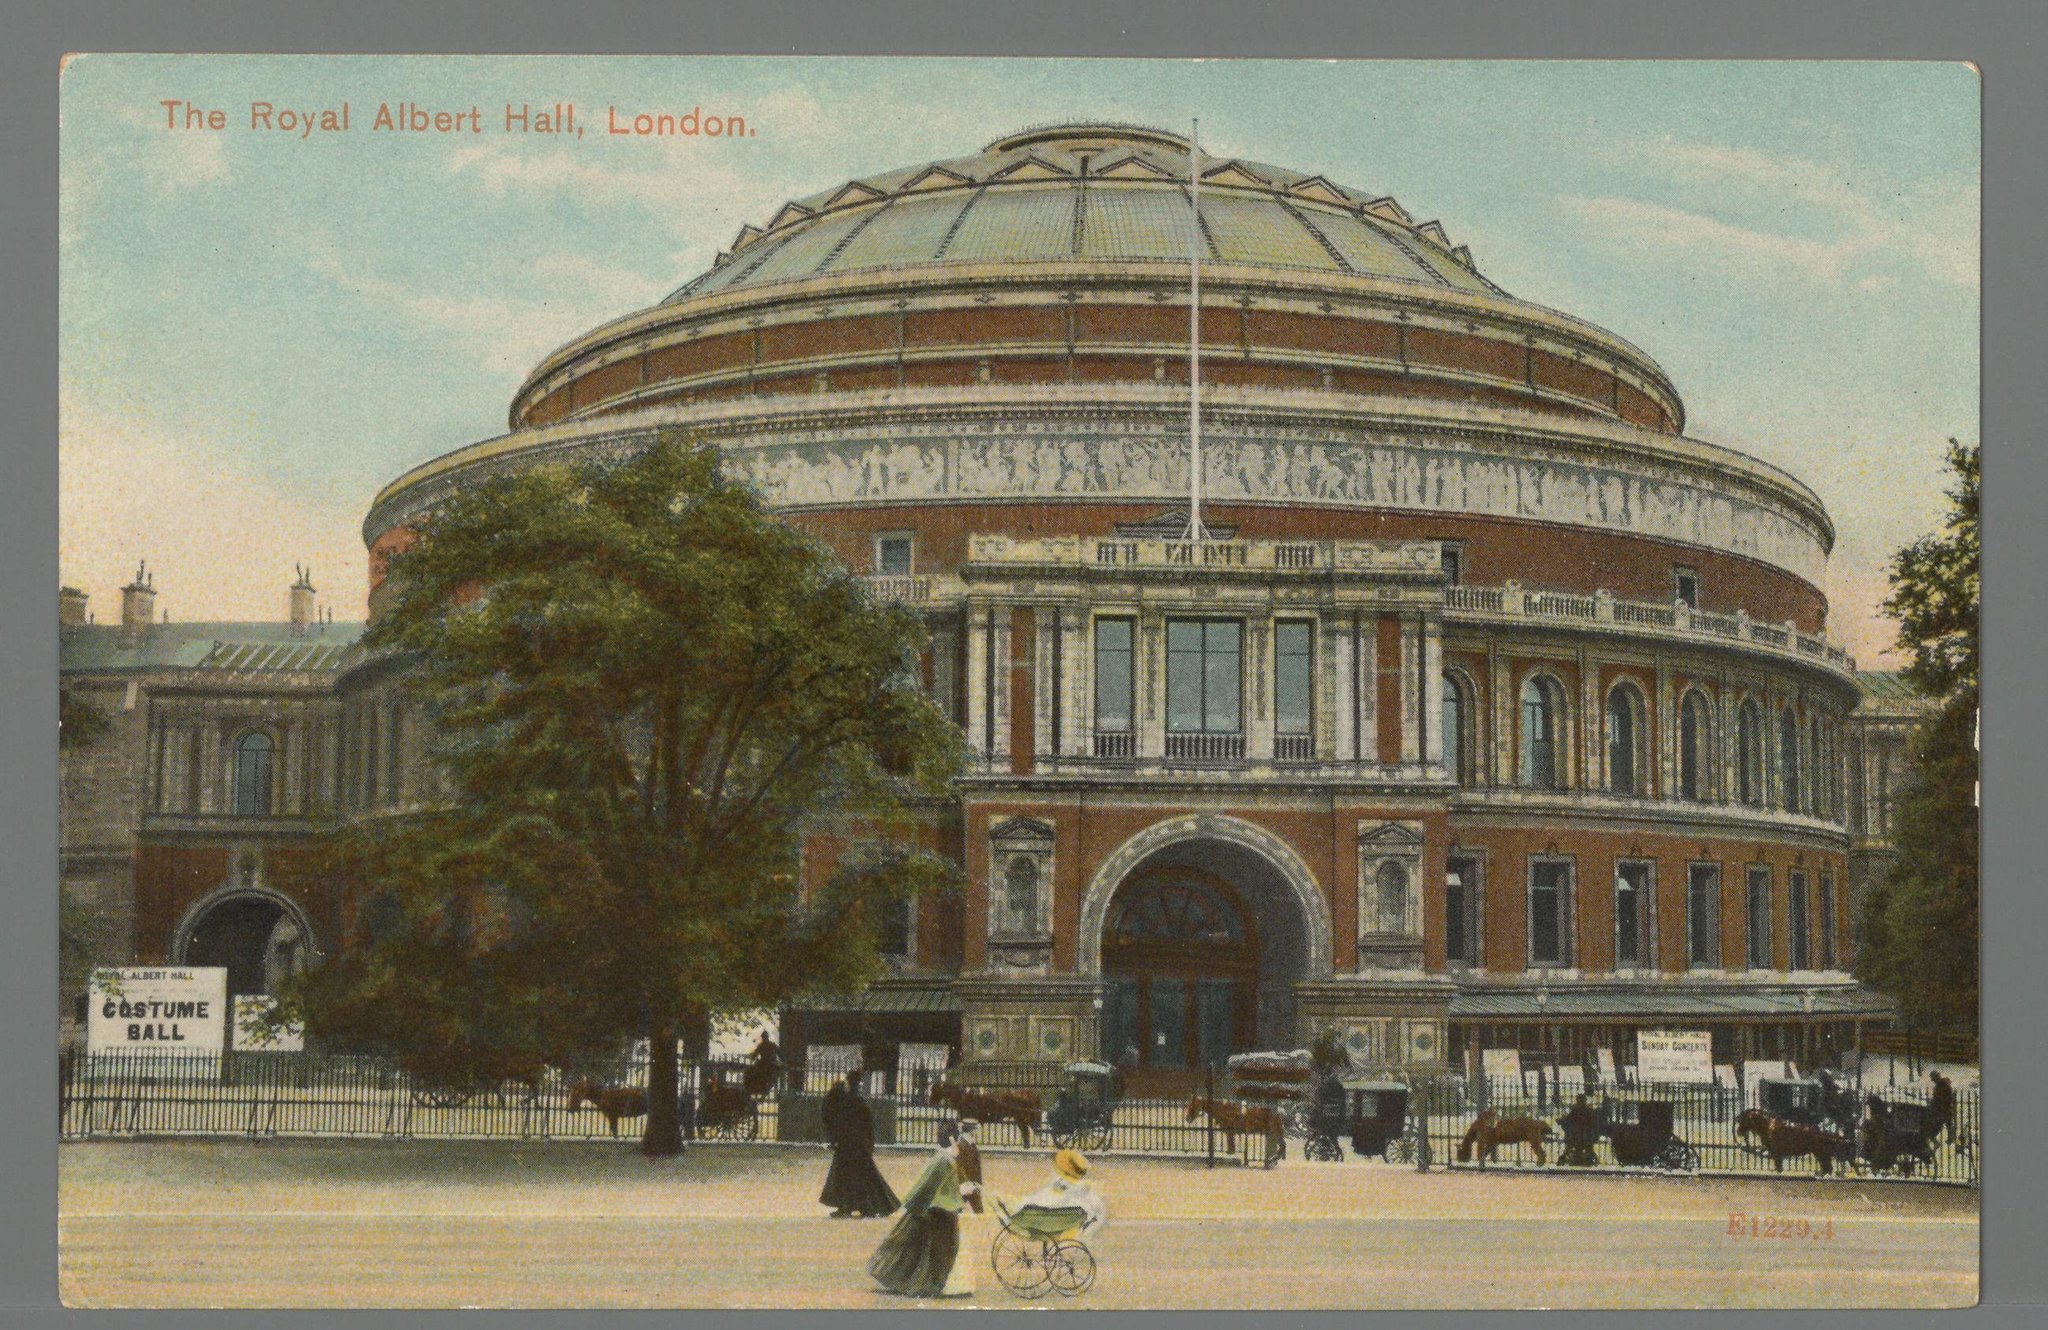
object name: photomechanical print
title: The Royal Albert Hall, London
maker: Anonymous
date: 1902-1918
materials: cardboard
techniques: lithograph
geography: london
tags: concert hall